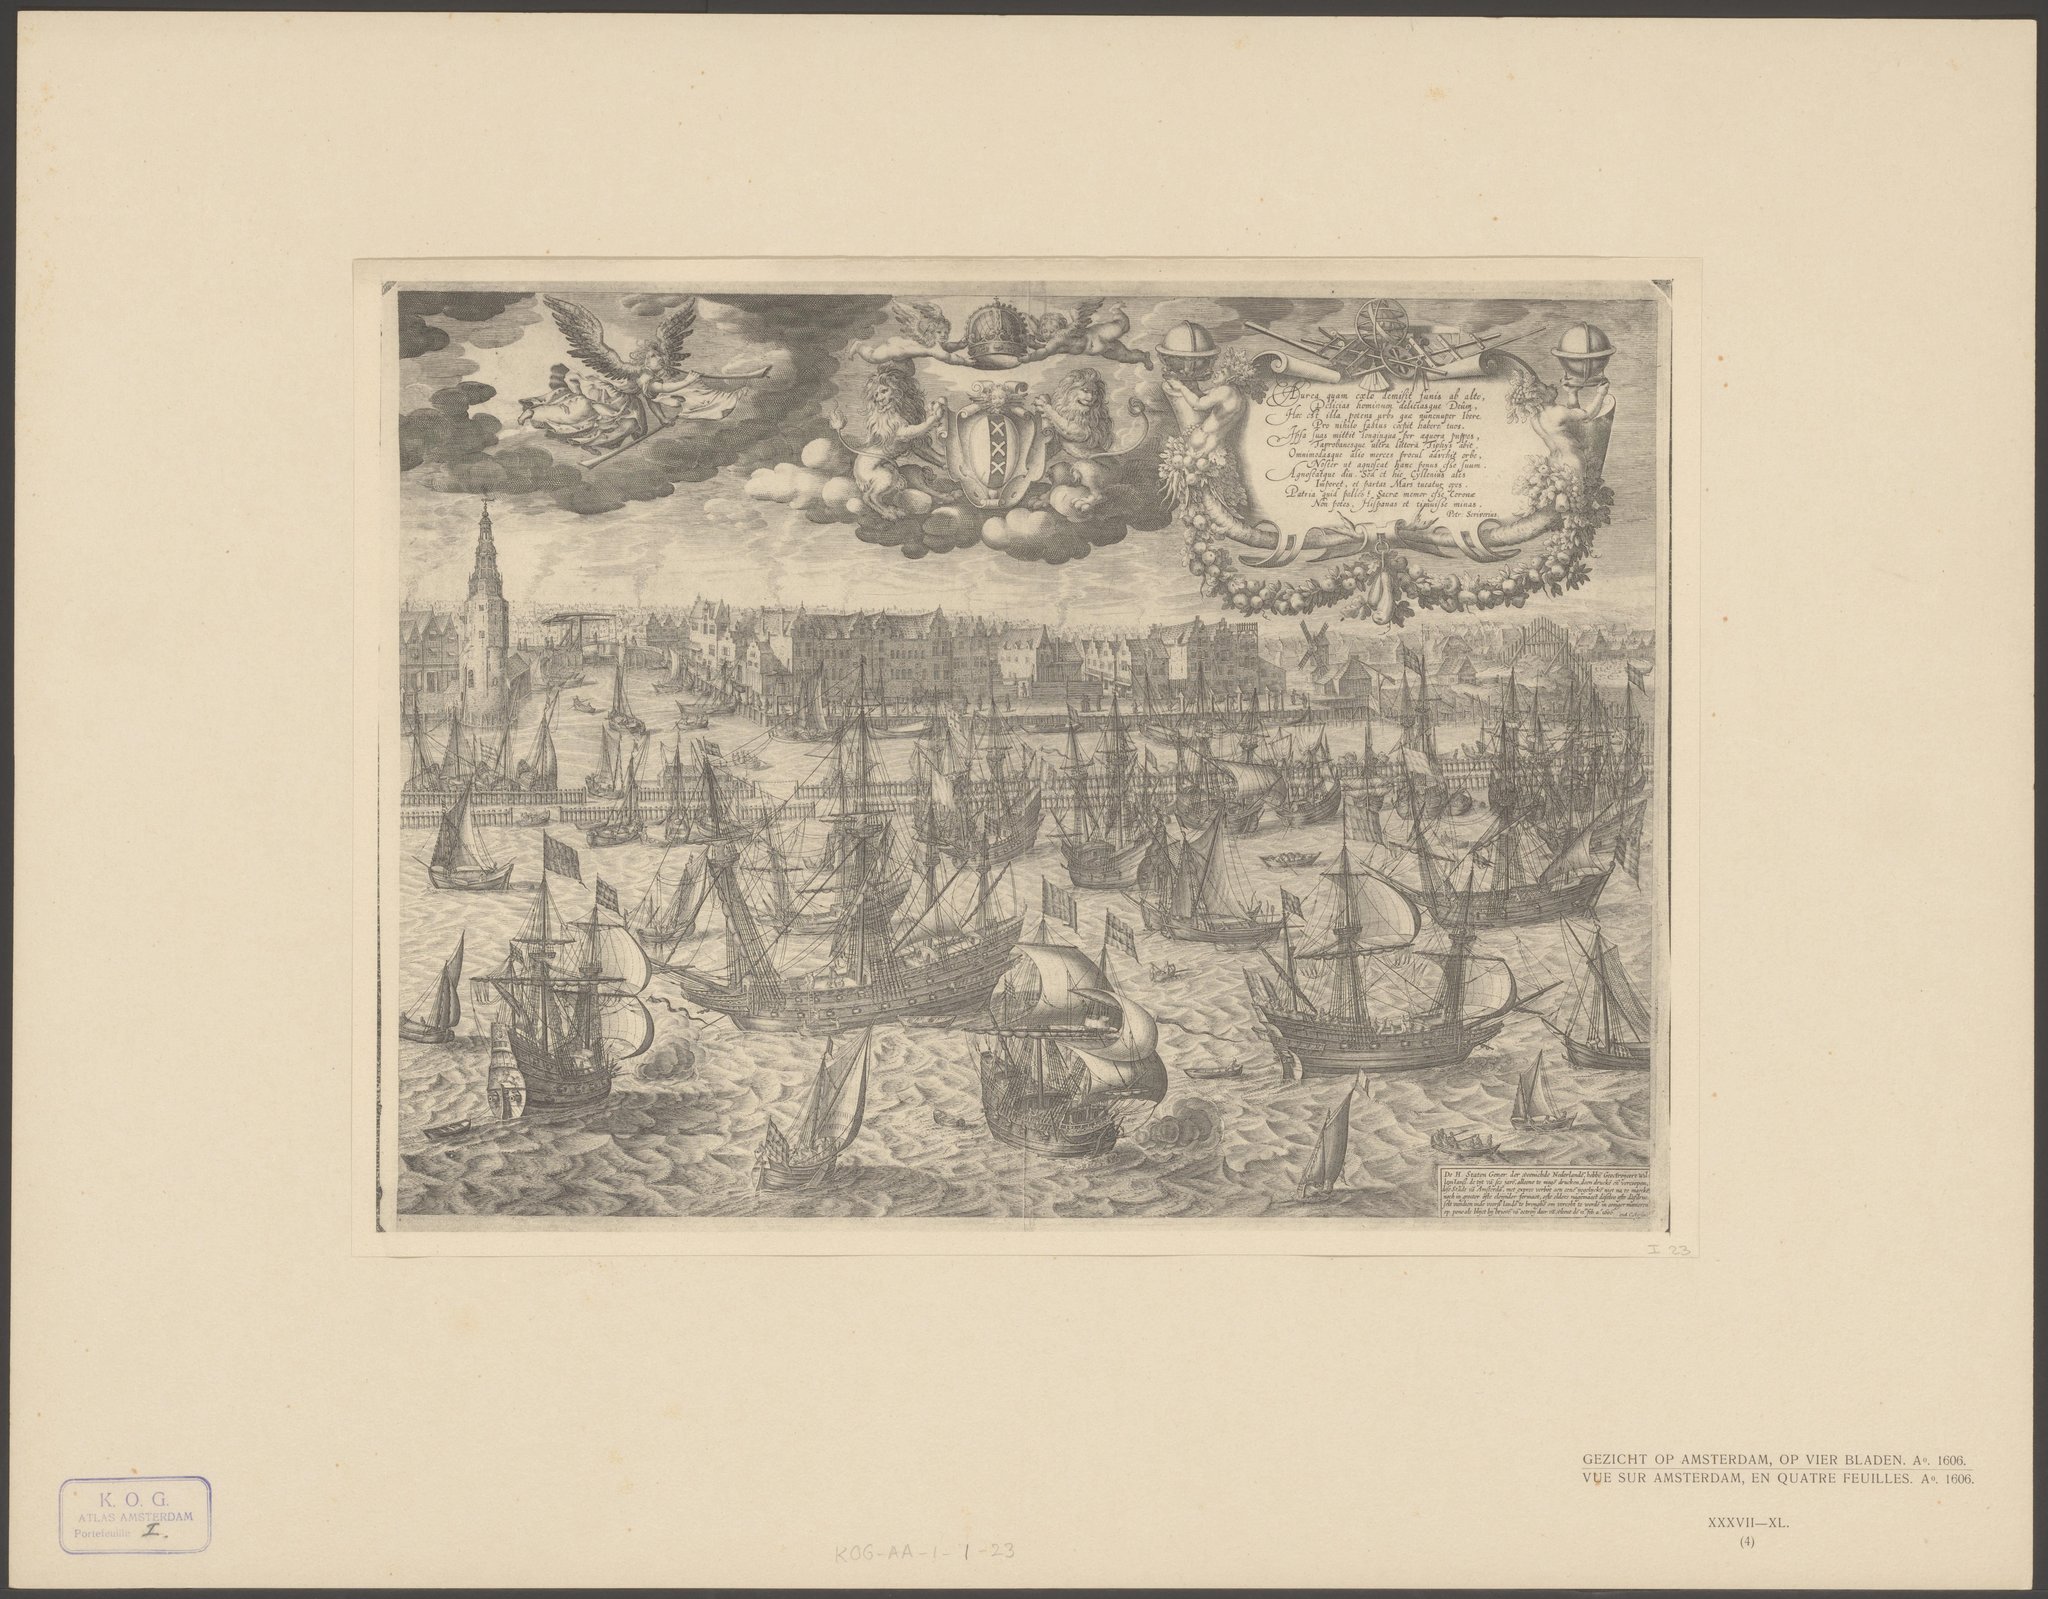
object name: photomechanical print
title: Gezicht op de stad Amsterdam vanaf het IJ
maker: Anonymous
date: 1875-1968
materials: paper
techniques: photograph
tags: city-view in general; 'veduta', river, ships (in general) - cc - more than one ship, amsterdam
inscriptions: collector's mark: ‘1’ Lugt 1641b, inscription: ‘Gezicht op Amsterdam, op vier bladen. Ao. 1606. / Vue sur Amsterdam, en quatre feuilles. Ao. 1606. / XXXVII-XL. / (4)’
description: Onderwerpsrubriek binnen de Atlas Amsterdam: Gezichten van den geheelen IJkant der Stad.